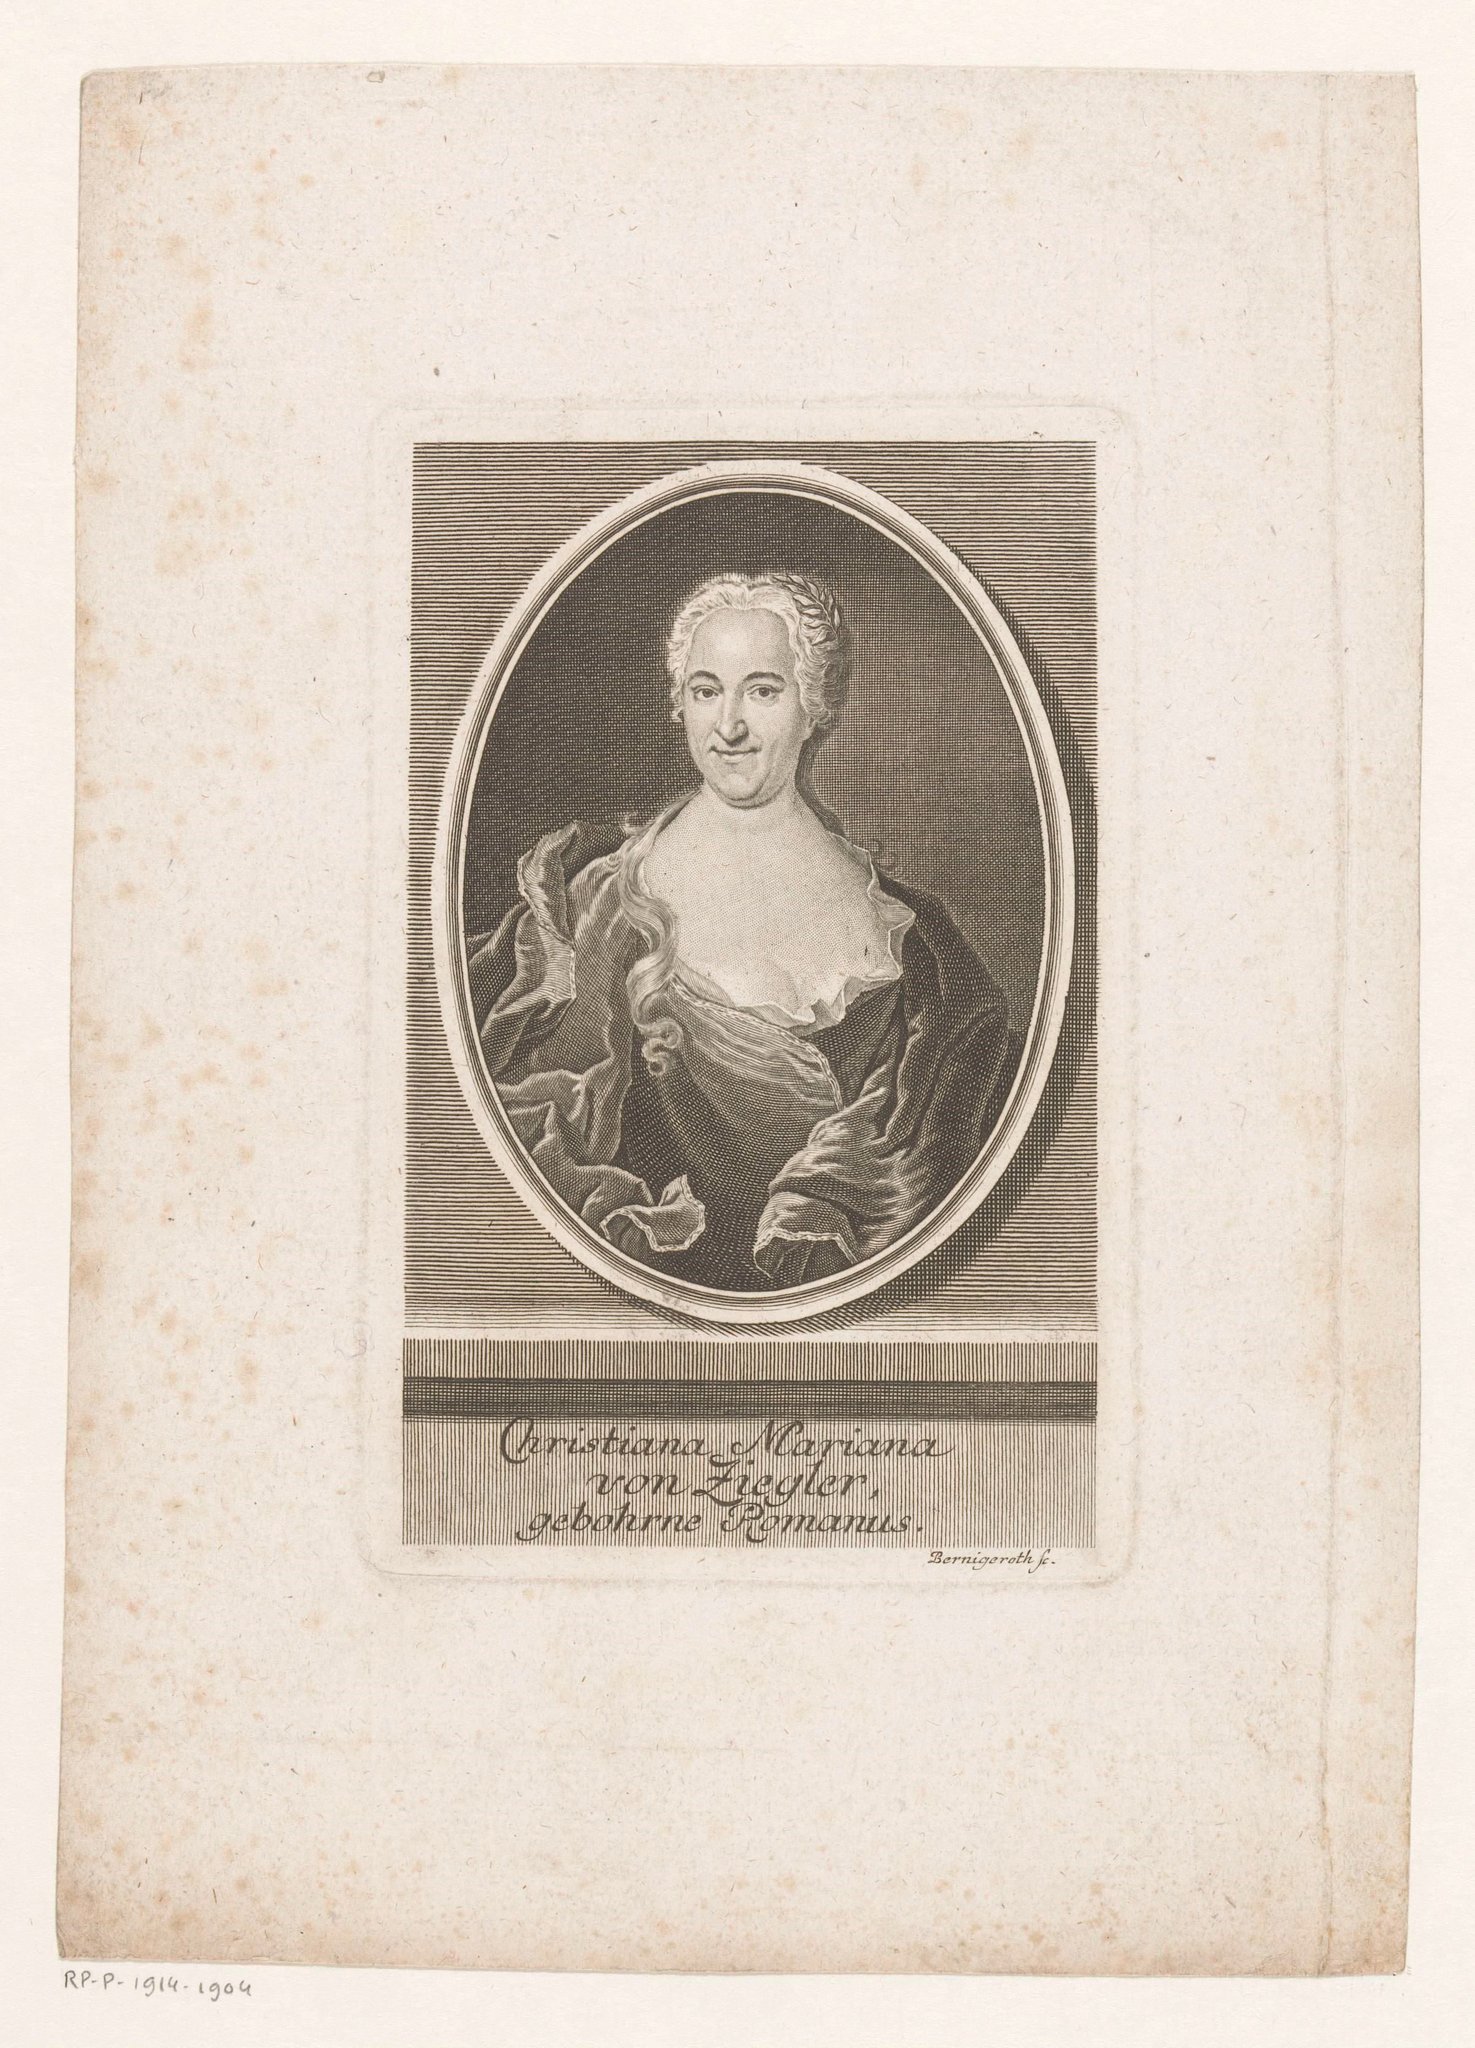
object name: print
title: Portret van Christiana Mariana von Ziegler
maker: johann martin bernigeroth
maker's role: print maker, publisher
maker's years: 1713-1767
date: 1740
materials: paper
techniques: engraving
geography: leipzig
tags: historical persons - bb - woman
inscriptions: collector's mark: Lugt 2228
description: Prent ook gebruikt in: Zuverlässige Nachrichten von dem gegenwärtigen Zustande, Veränderung und Wachsthum der Wissenschaften. dl. 2. Leipzig: Johann Friedrich Gleditsch, 1740.